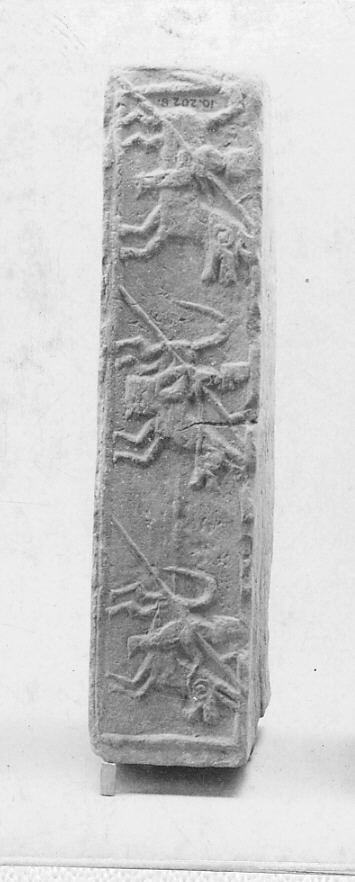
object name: tile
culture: chinese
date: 221 BCE-220 CE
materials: earthenware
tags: human figures,animals,weapons